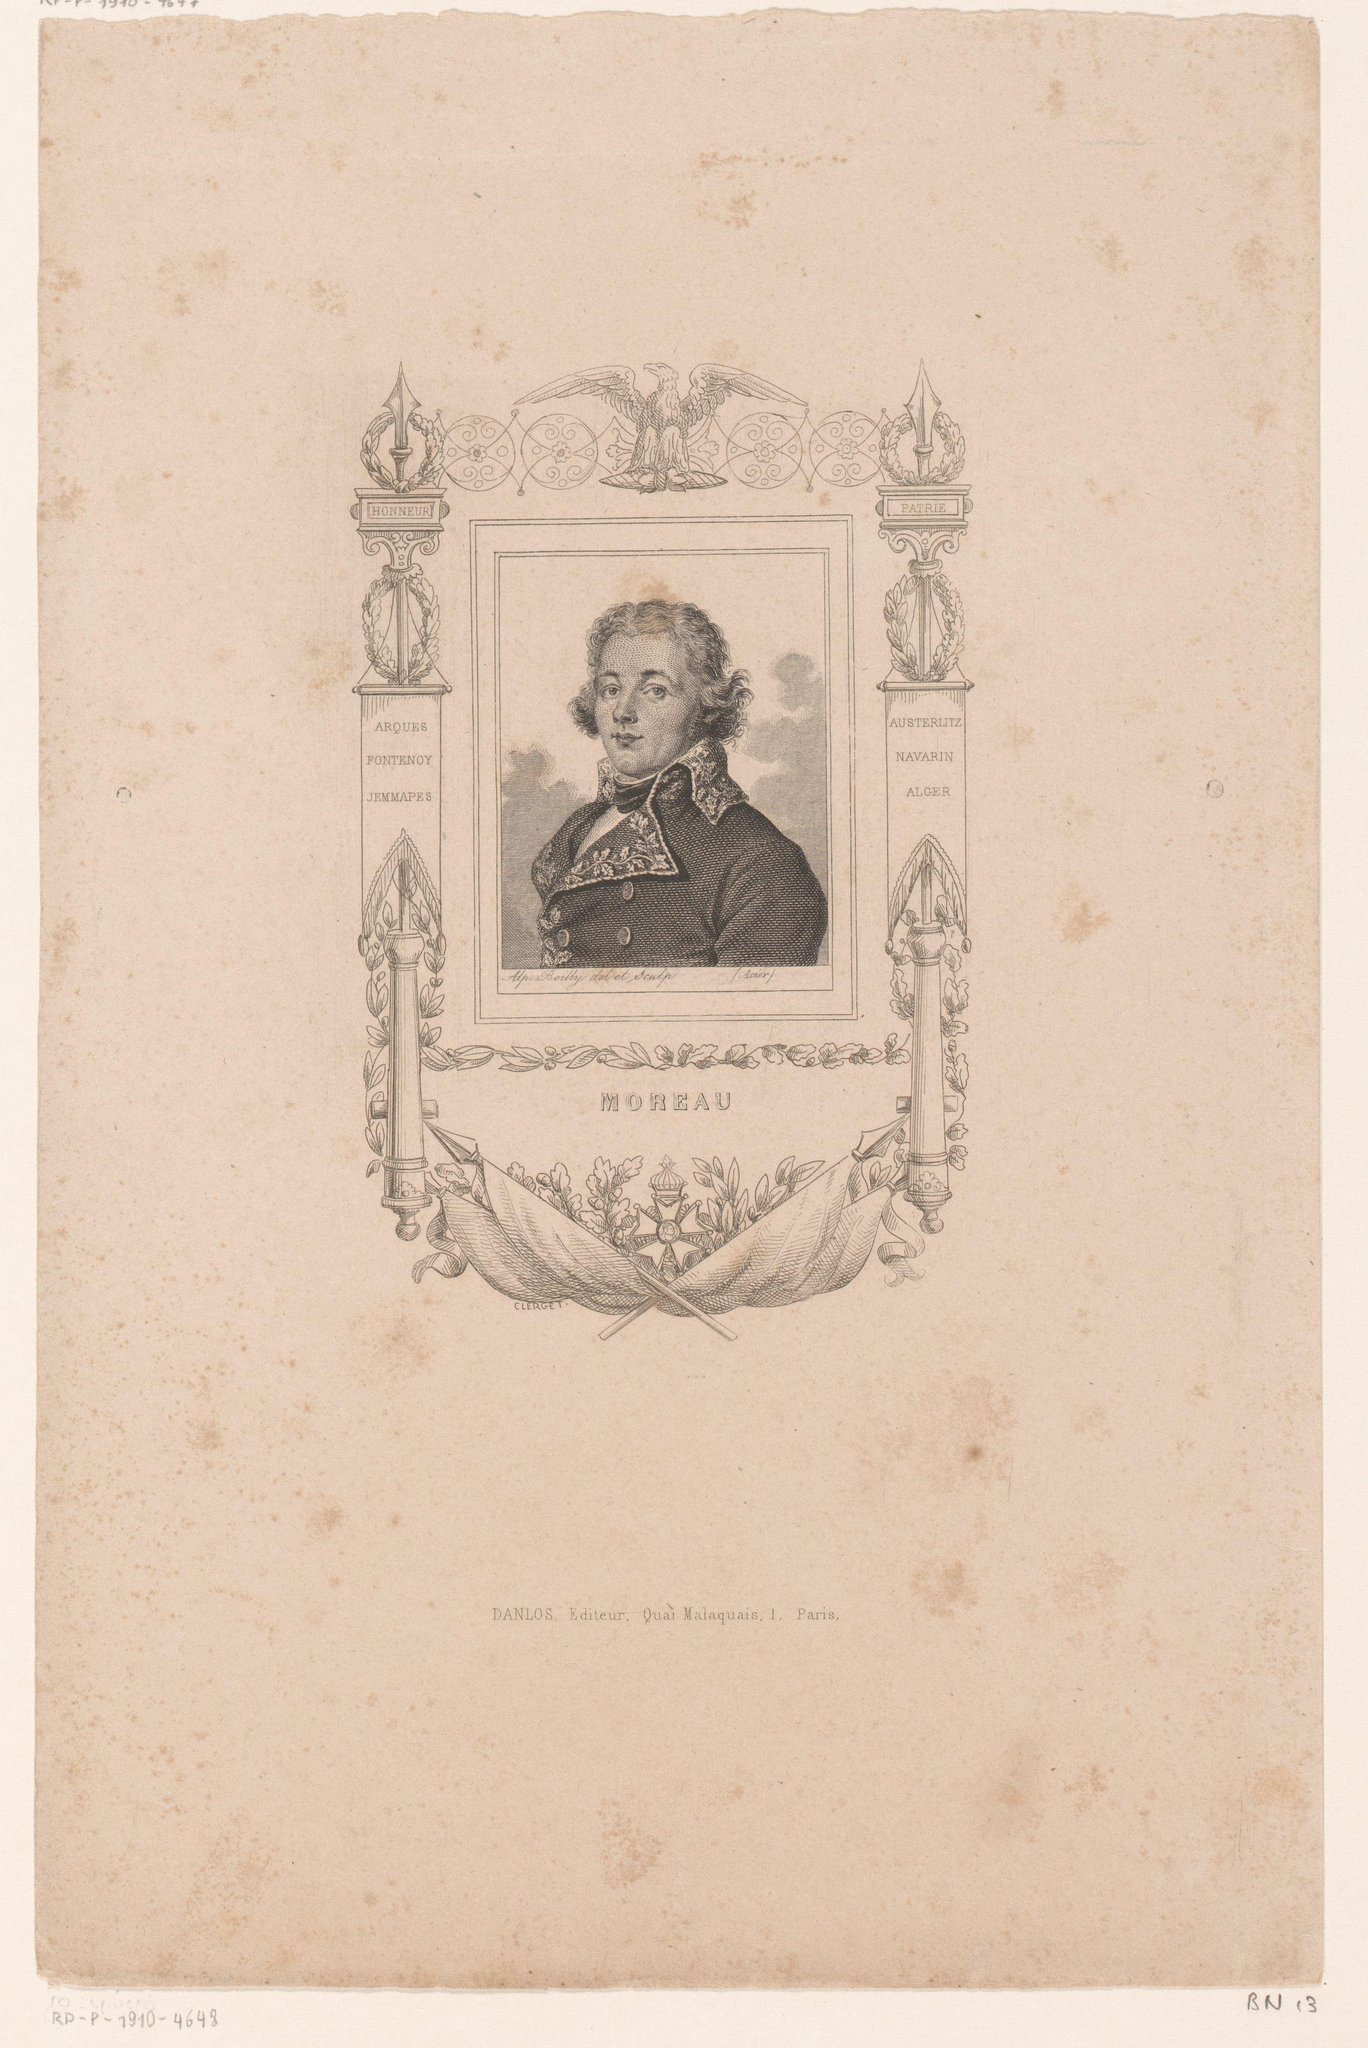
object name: print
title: Portret van Jean Victor Marie Moreau in een versierde cartouche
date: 1828-1867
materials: paper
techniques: etching, engraving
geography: france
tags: historical persons, ornament ~ cartouche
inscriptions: collector's mark: Lugt 2228